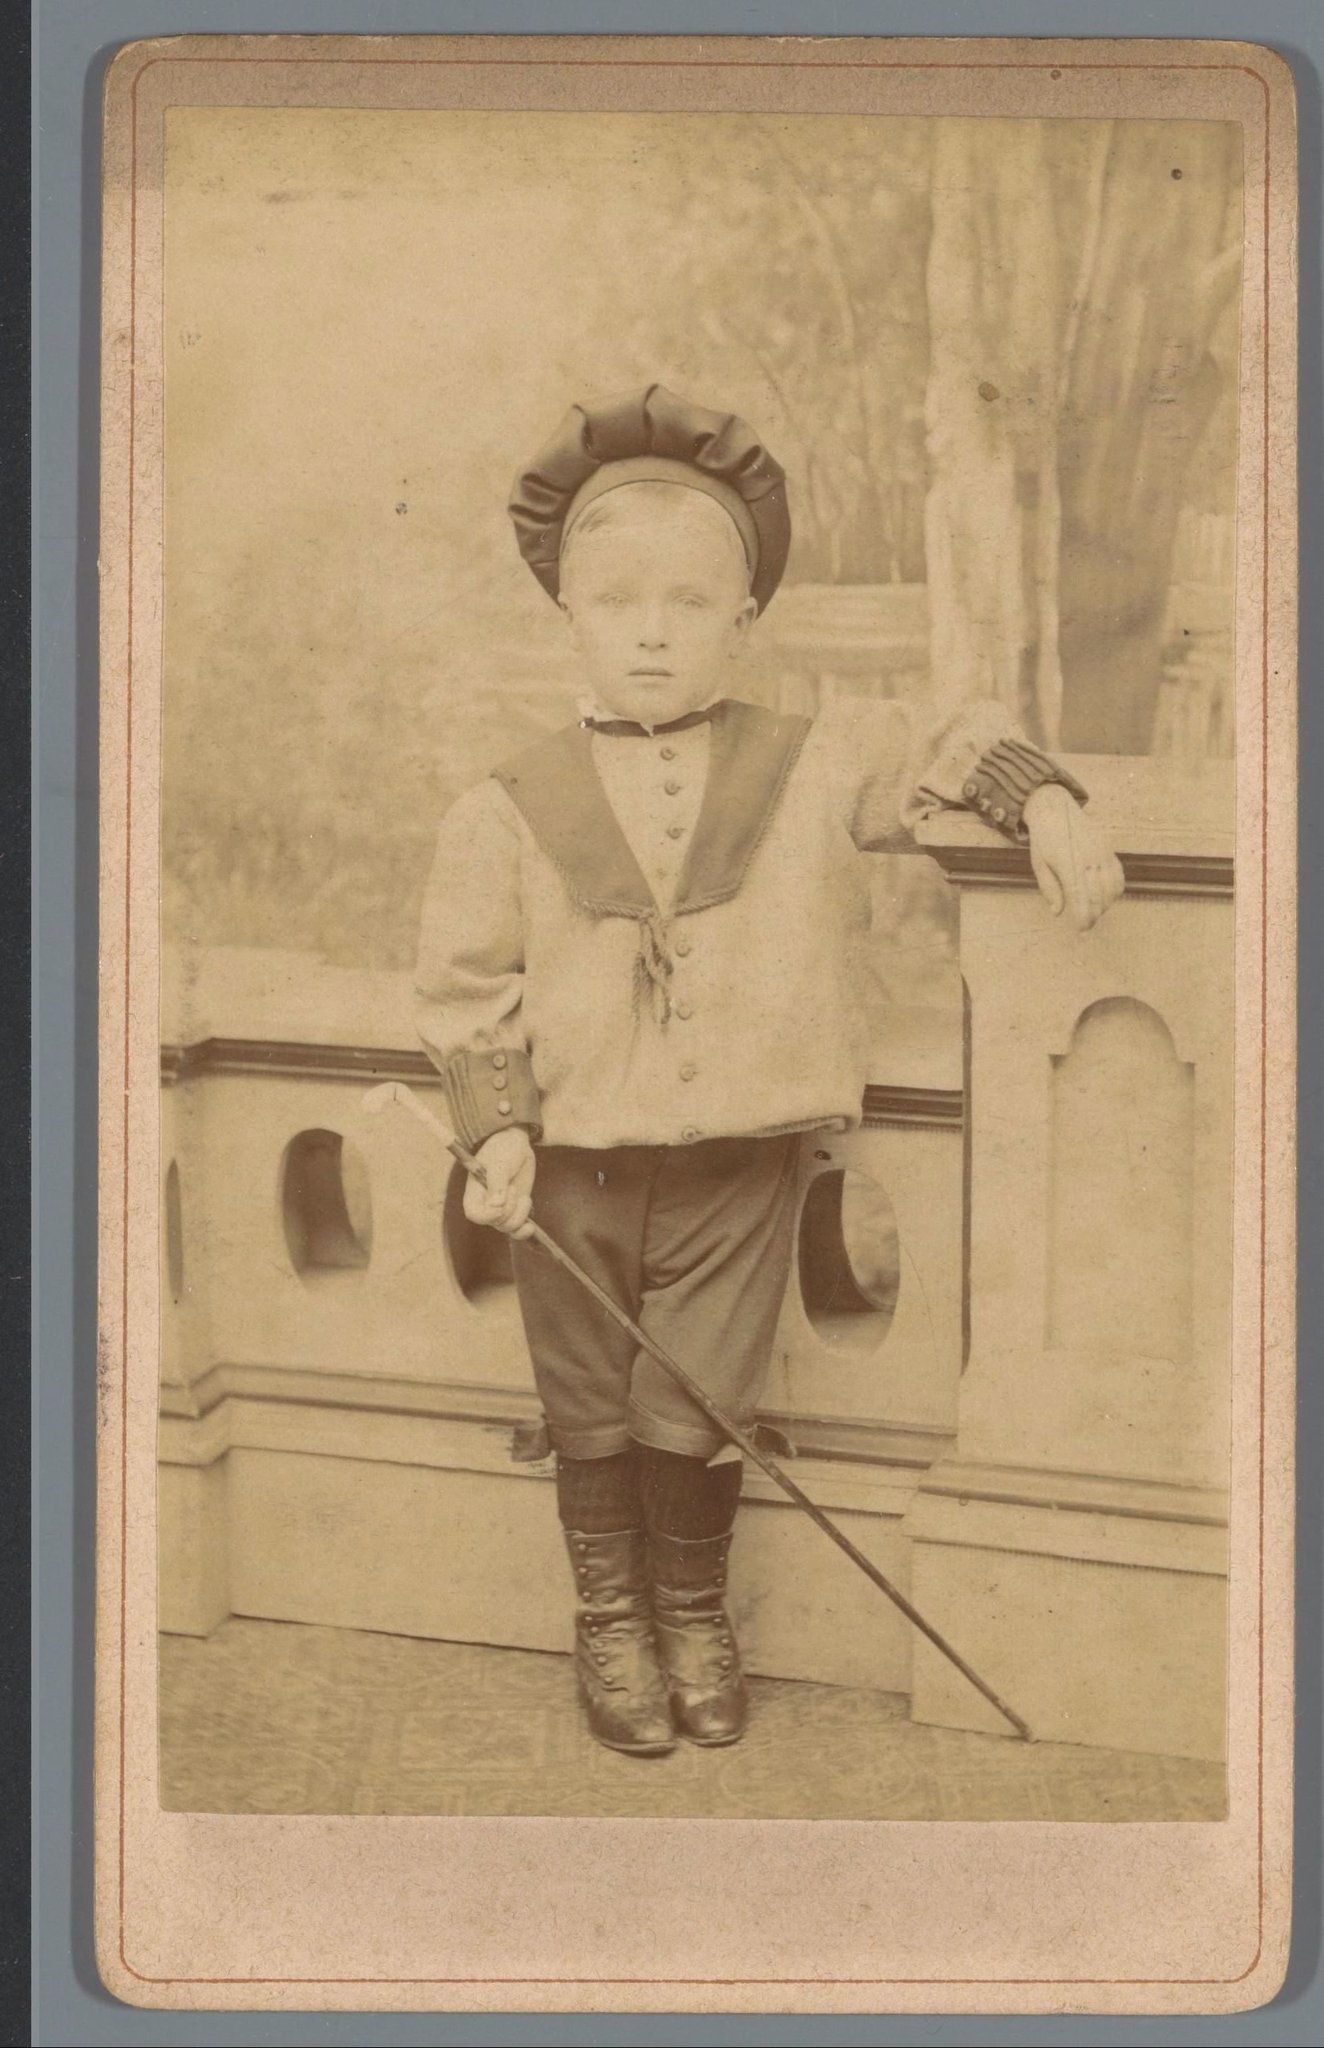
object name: carte de visite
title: Portret van een onbekende jongen met wandelstok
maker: jan siewers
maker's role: fotograaf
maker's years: 1848-1918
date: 1890-1918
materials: cardboard, paper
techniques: albumen print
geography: hilversum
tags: boy (child between toddler and youth), anonymous historical person portrayed